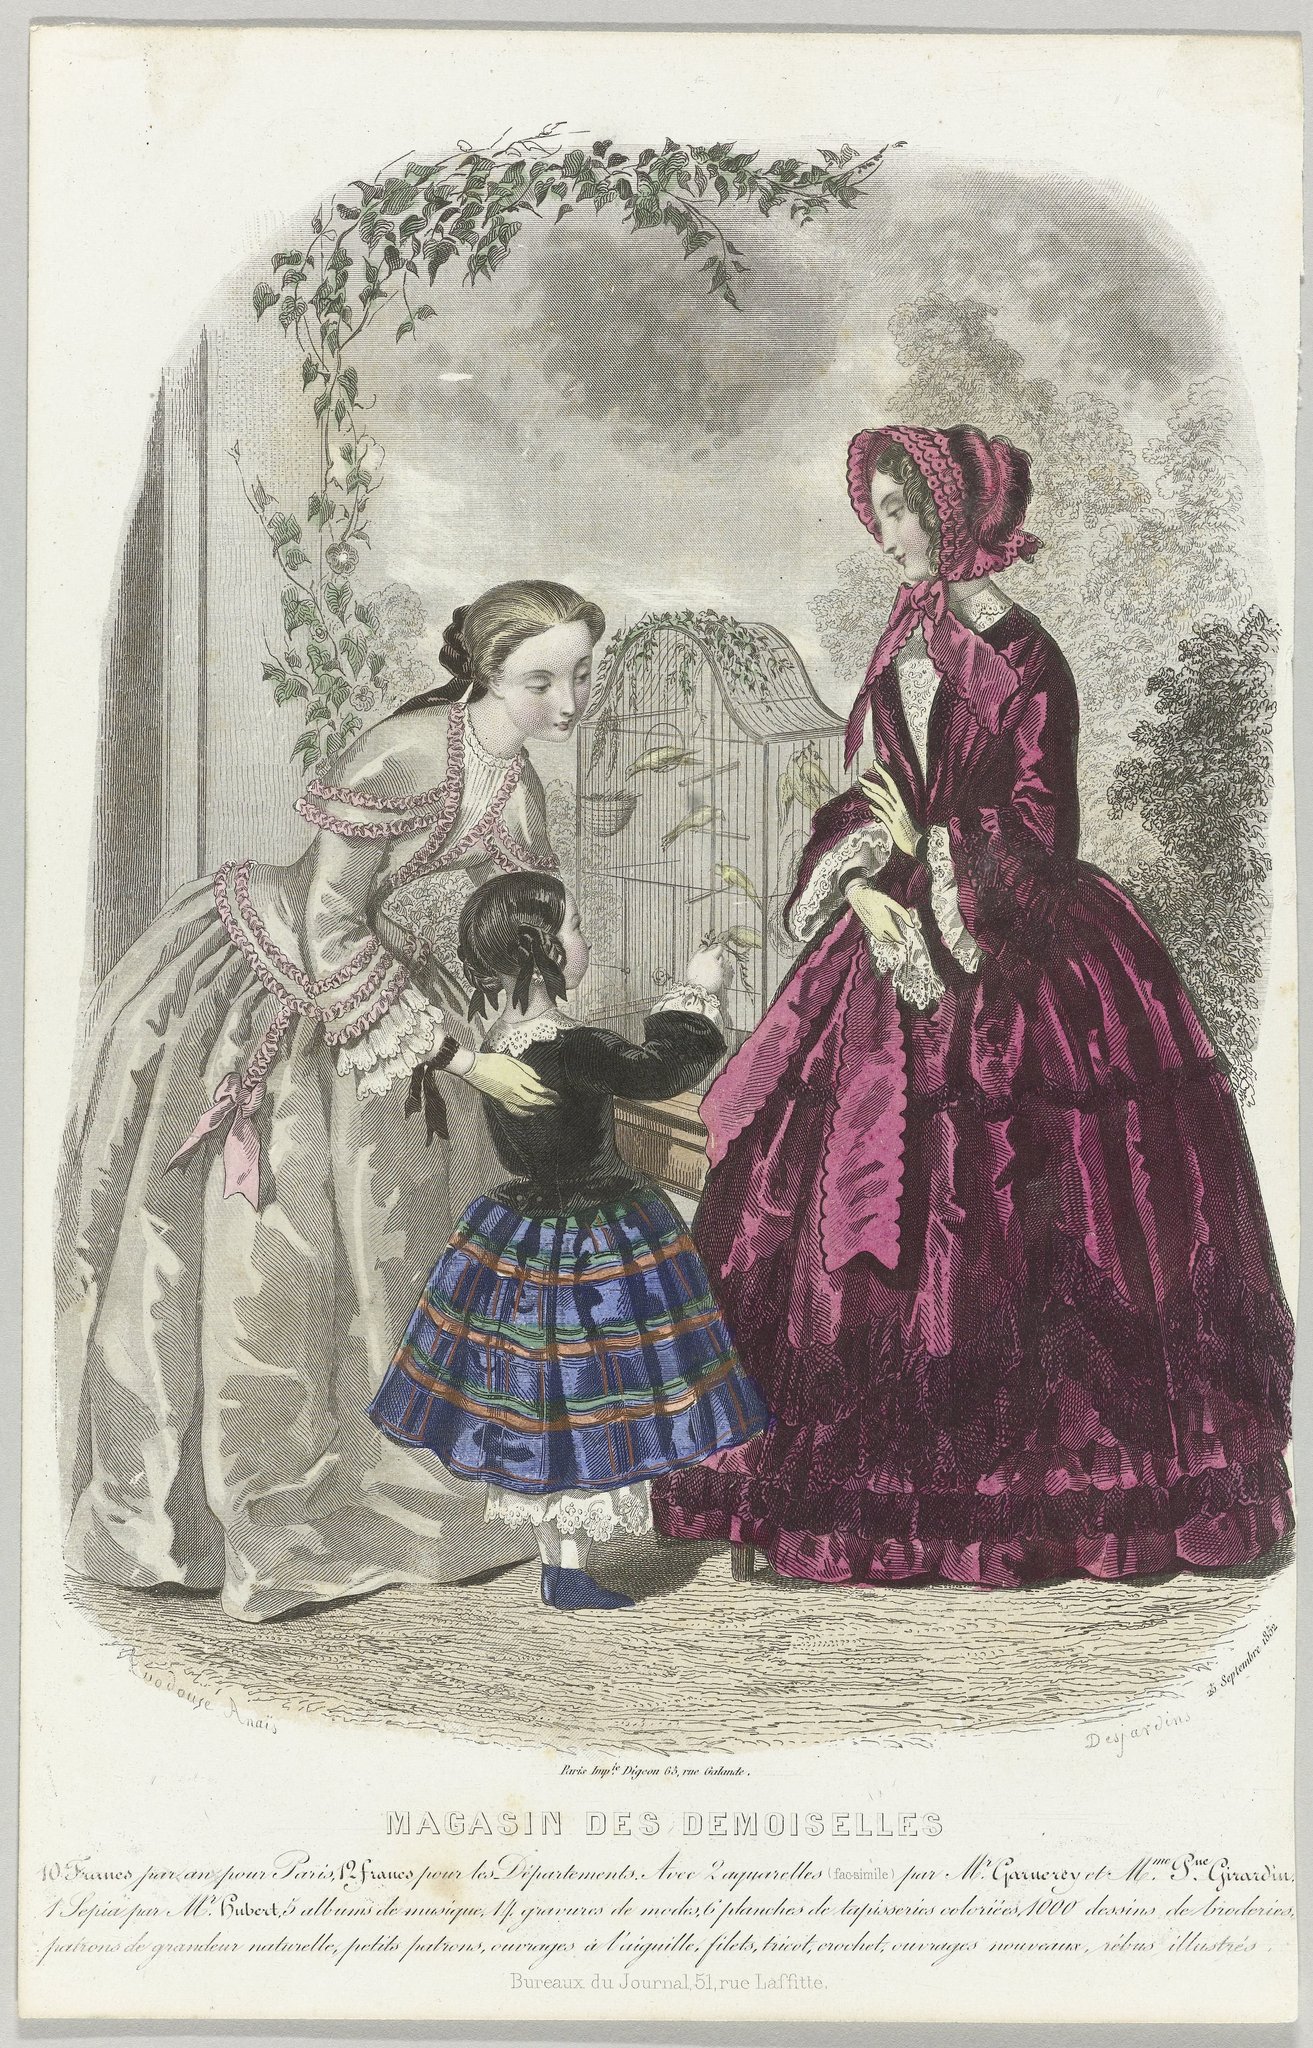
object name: fashion print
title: Magasin des Demoiselles, 25 septembre 1852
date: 1852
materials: paper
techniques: hand coloring, engraving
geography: paris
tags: handkerchief (+ women's clothes), skirt (+ girls' clothes), underclothes for the lower part of the body: bloomers (+ girls' clothes), clothing for the upper part of the body (+ girls' clothes), fashion plates, head-gear: hat (+ women's clothes), gloves, mittens, etc. (+ women's clothes), bird in a cage, neck-gear ~ clothing (+ women's clothes), bracelet, wristlet (+ women's clothes)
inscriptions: address: ‘Bureaux du Journal, 51, rue Laffitte.’, caption: ‘10 Francs par an pour Paris 12 francs pour les Départements, avec 2 Aquarelles (fac-simile) par M.rGaruery et M.me P.ue Girardin 1 Sepia par M.r Hubert, 5 Albums de musique, 14 gravures de modes, 6 planches de tapisseries coloriées, 1000 dessins de broderies, patrons de grandeur naturelle, petits patrons, ouvrages à l'aiguille, filet, tricot, crochet, ouvrages nouveaux, rébus illustrés.’, title: ‘Magasin des Demoiselles’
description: Twee vrouwen en een meisje bij een vogelkooi. Onder de voorstelling enkele regels informatie over het modetijdschrift. Prent uit het modetijdschrift Magasin des Demoiselles (1844-1896).